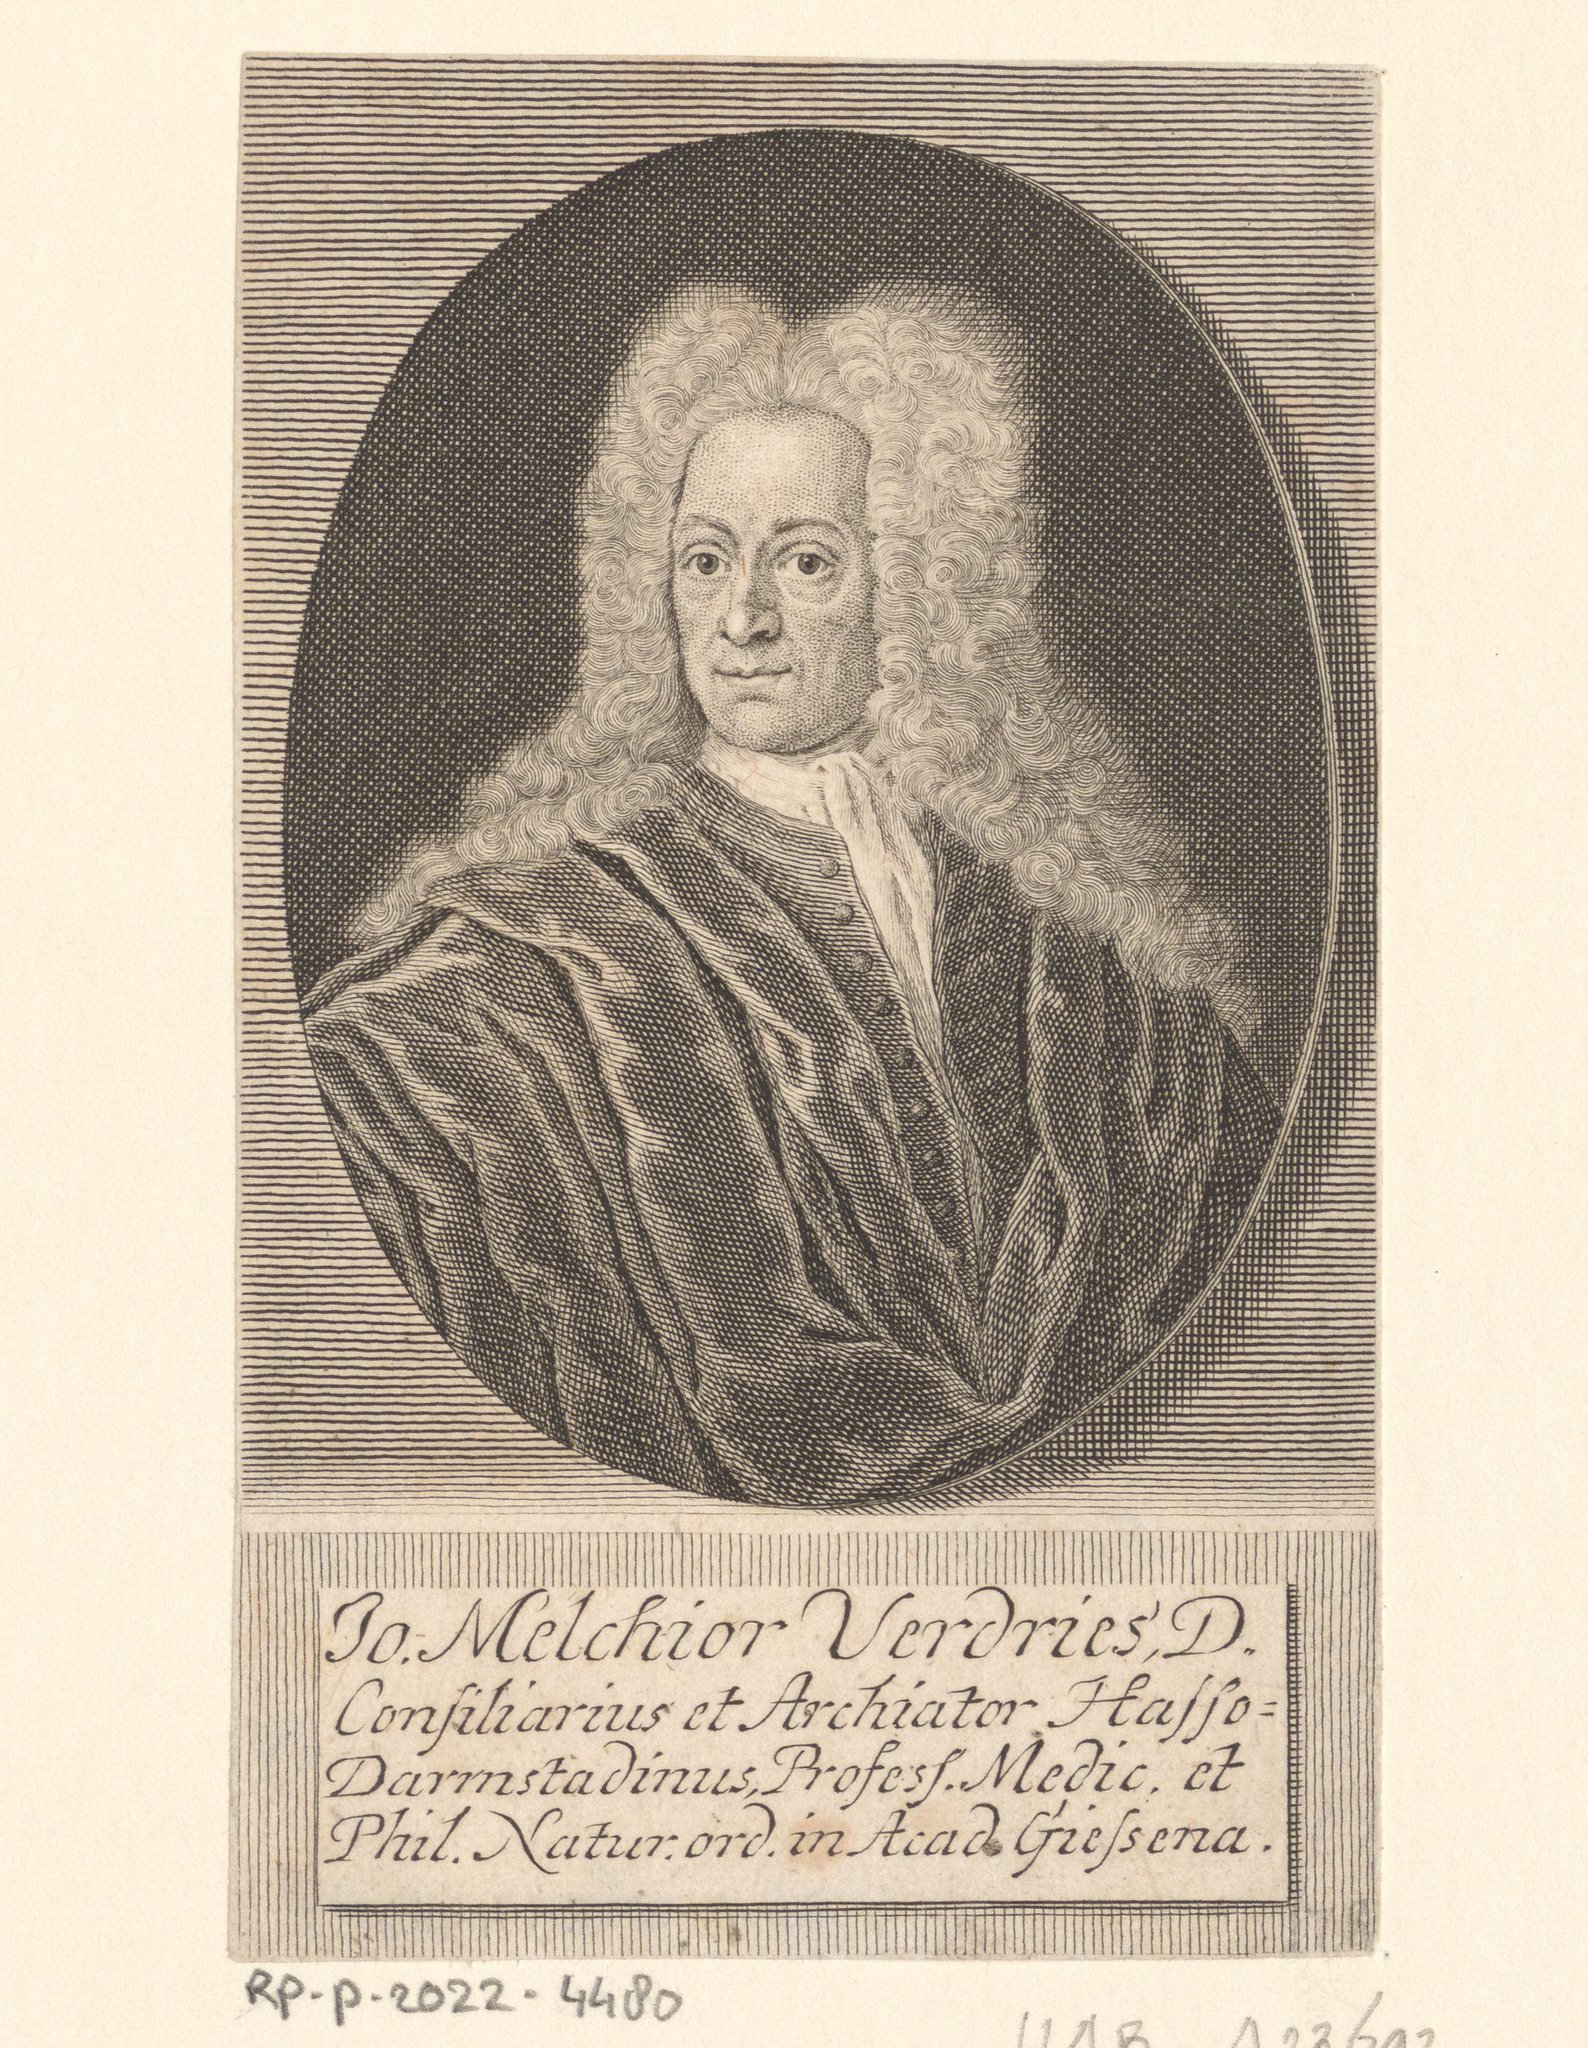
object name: print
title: Portret van Johann Melchior Verdries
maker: martin bernigeroth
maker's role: print maker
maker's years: 1670-1733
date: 1731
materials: paper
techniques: engraving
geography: germany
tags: theologian, historical persons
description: Prent waarschijnlijk uit: Deutsche Acta Eruditorum (...). dl. 158. Leipzig: Johann Gottlieb Gleditsch, 1731.